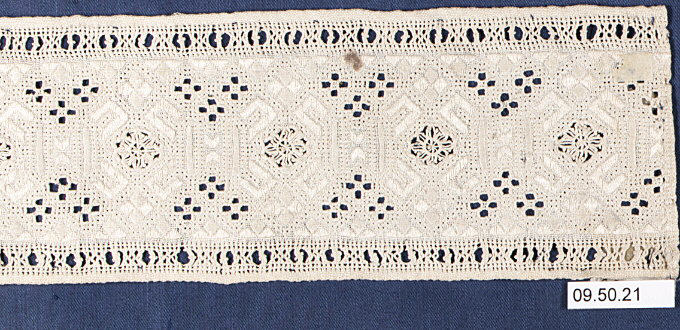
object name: strip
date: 1801-1900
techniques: embroidery